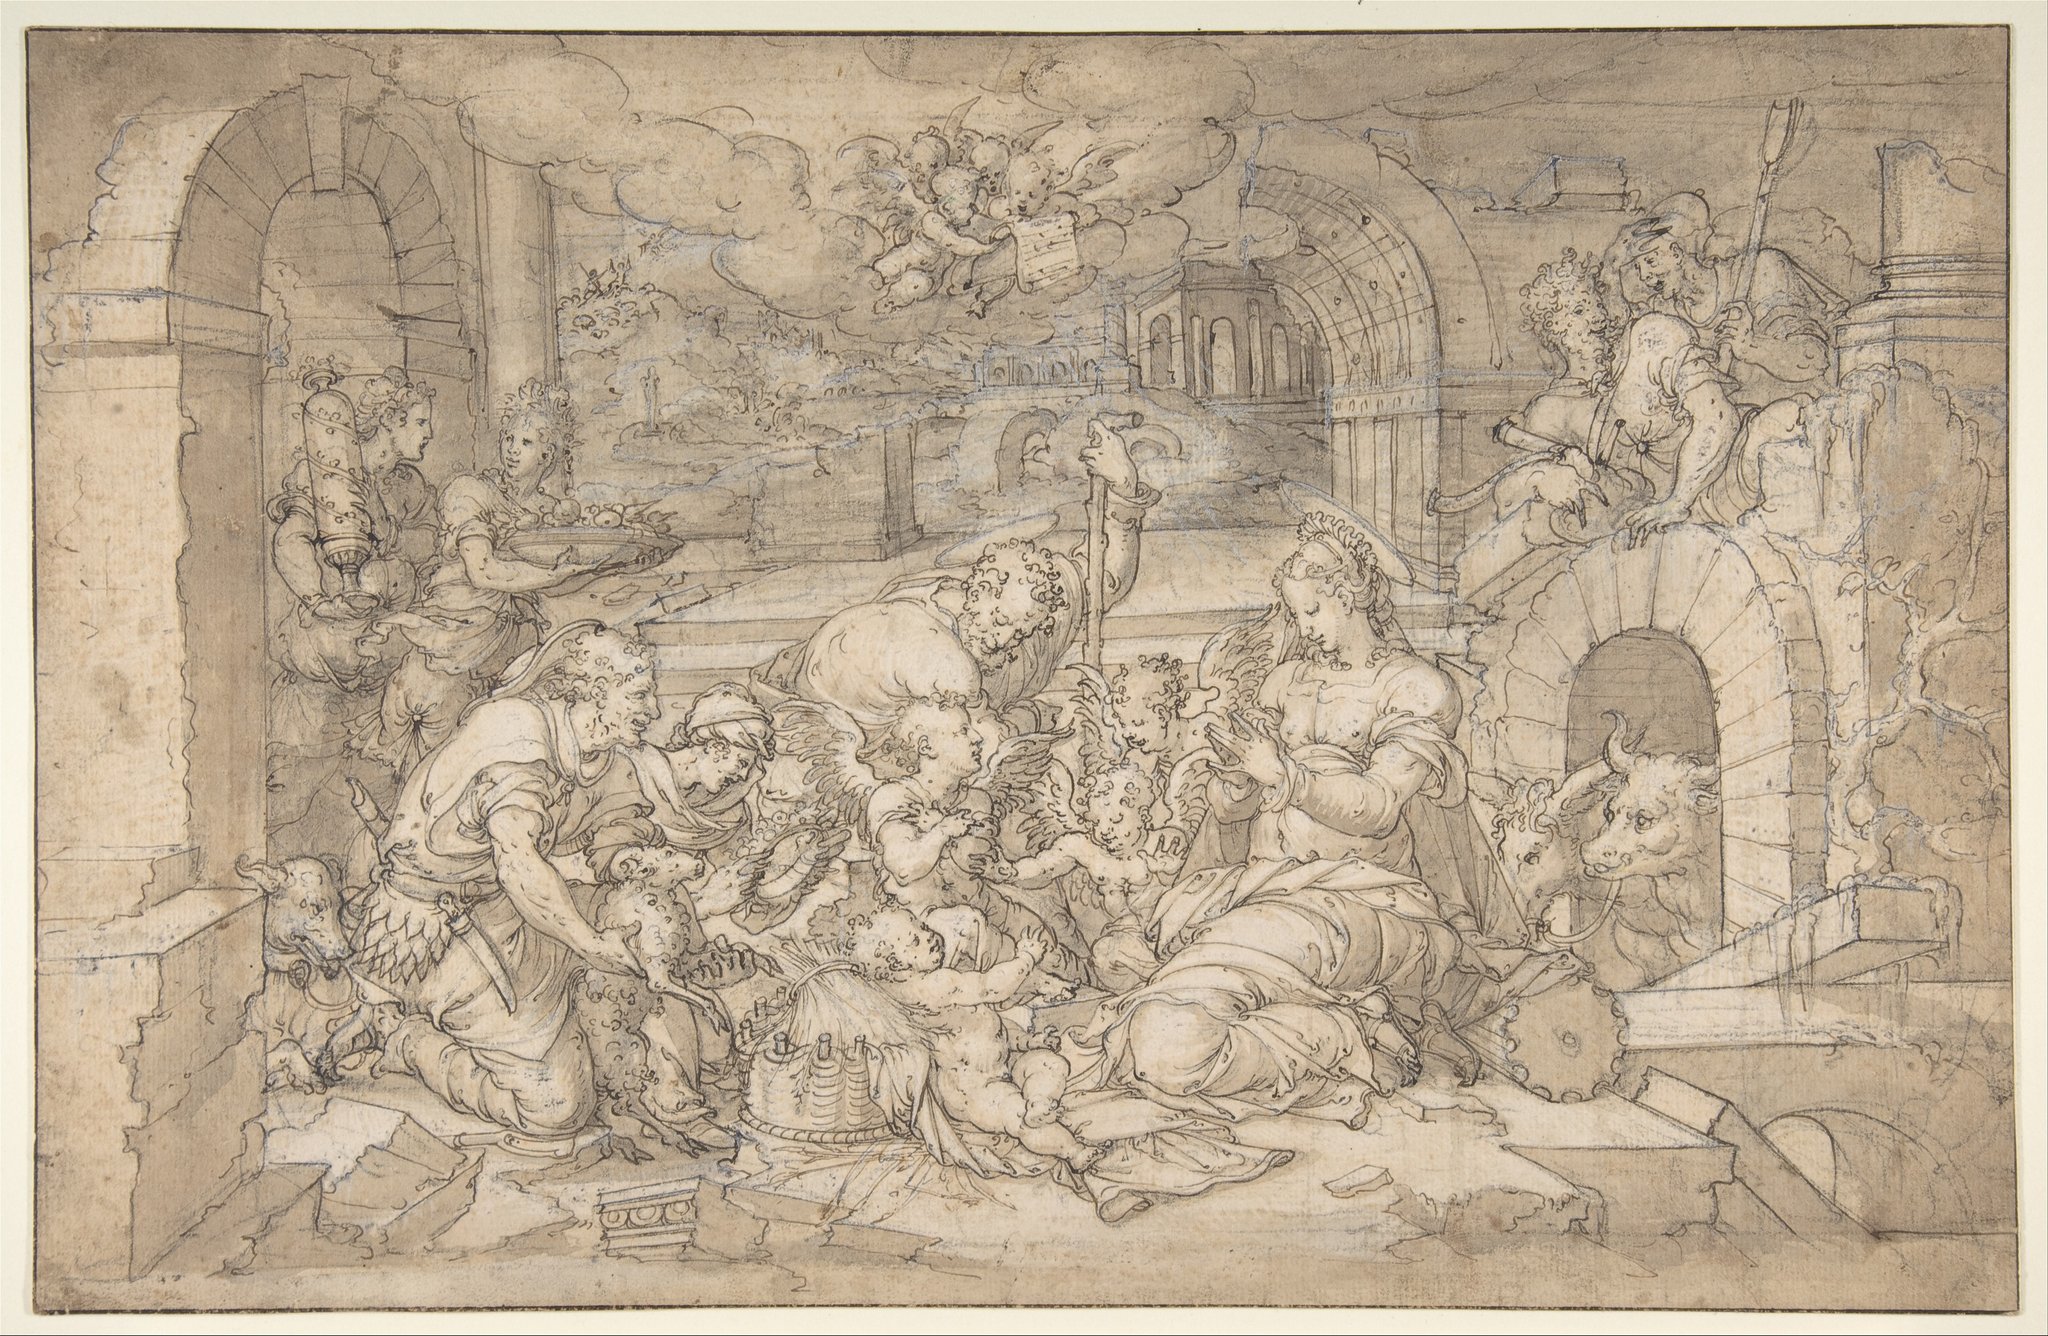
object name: drawing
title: The Adoration of the Shepherds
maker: jean cousin the younger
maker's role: artist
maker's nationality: french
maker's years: 1522-1594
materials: chalk, gouache, ink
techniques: brush, heightening, pen, wash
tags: sheep,angels,virgin mary,adoration of the shepherds,shepherds